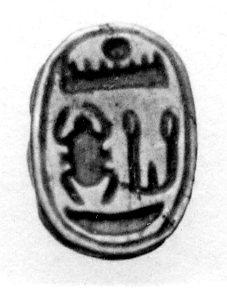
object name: scarab, thutmose iii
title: Scarab of Thutmose III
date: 1479-1425 BCE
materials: stone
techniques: glazing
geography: egypt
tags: hieroglyphs,scarabs